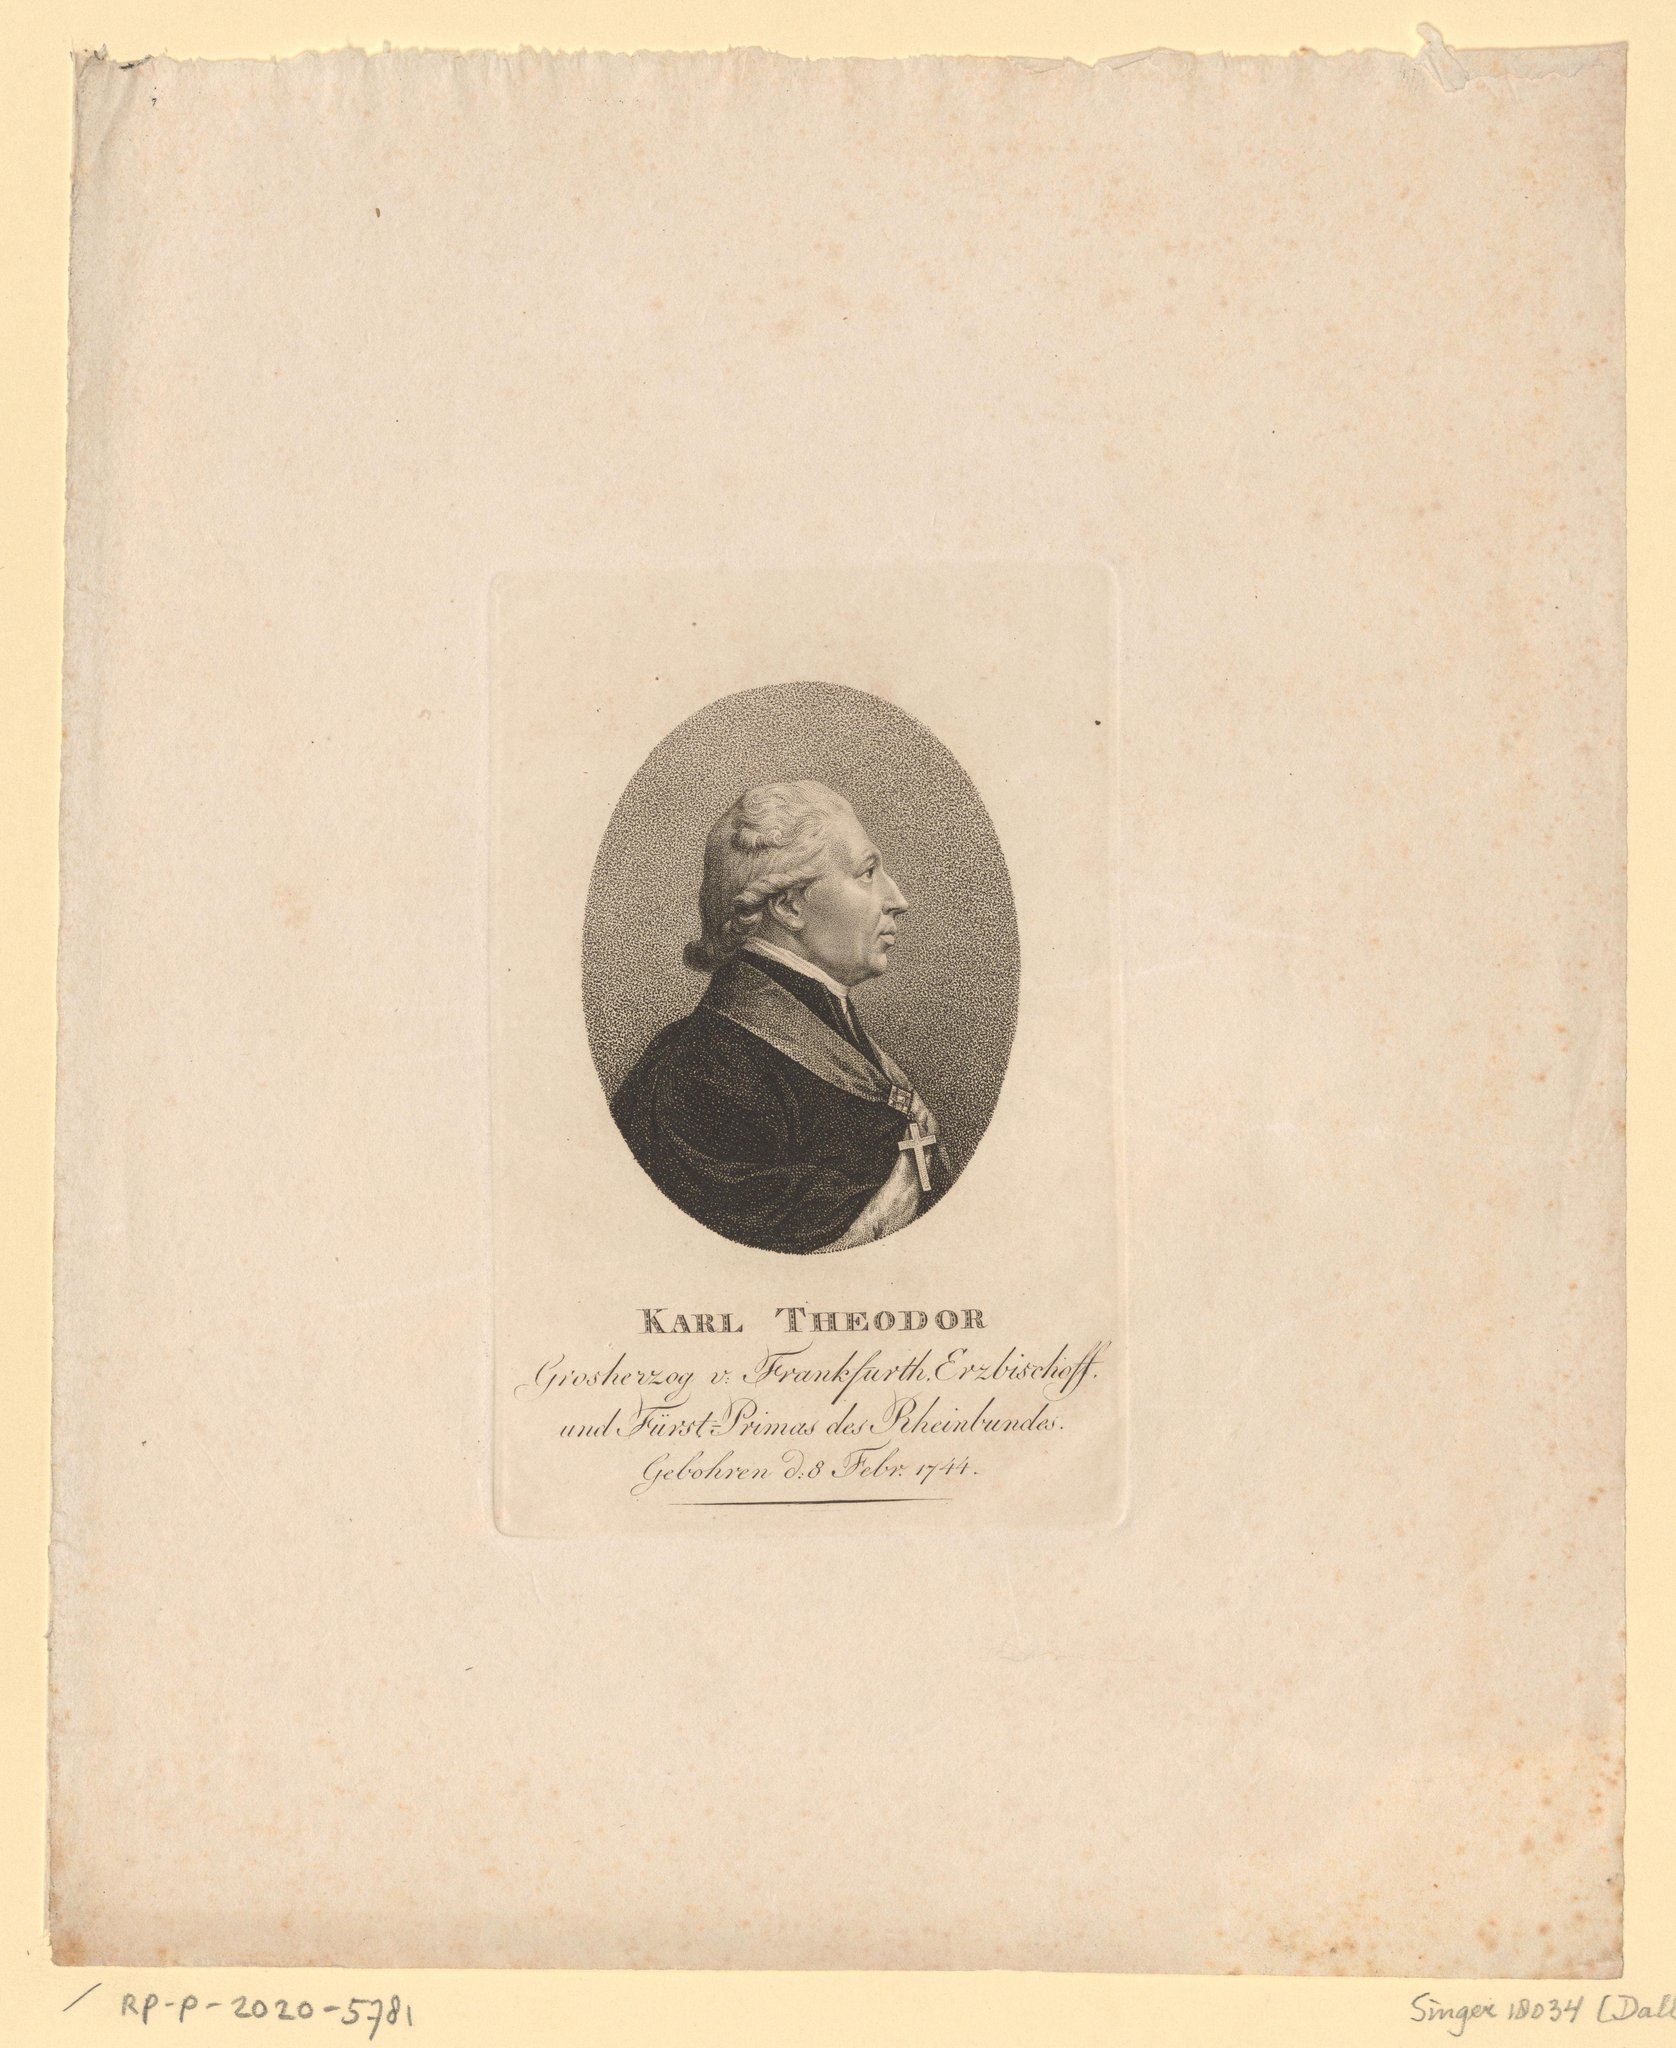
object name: print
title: Portret van Karl Theodor von Dalberg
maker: Anonymous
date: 1810-1817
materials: paper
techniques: stippling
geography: germany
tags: priest, karl theodor von dalberg, archbishop, bishop, etc. (roman catholic), historical persons